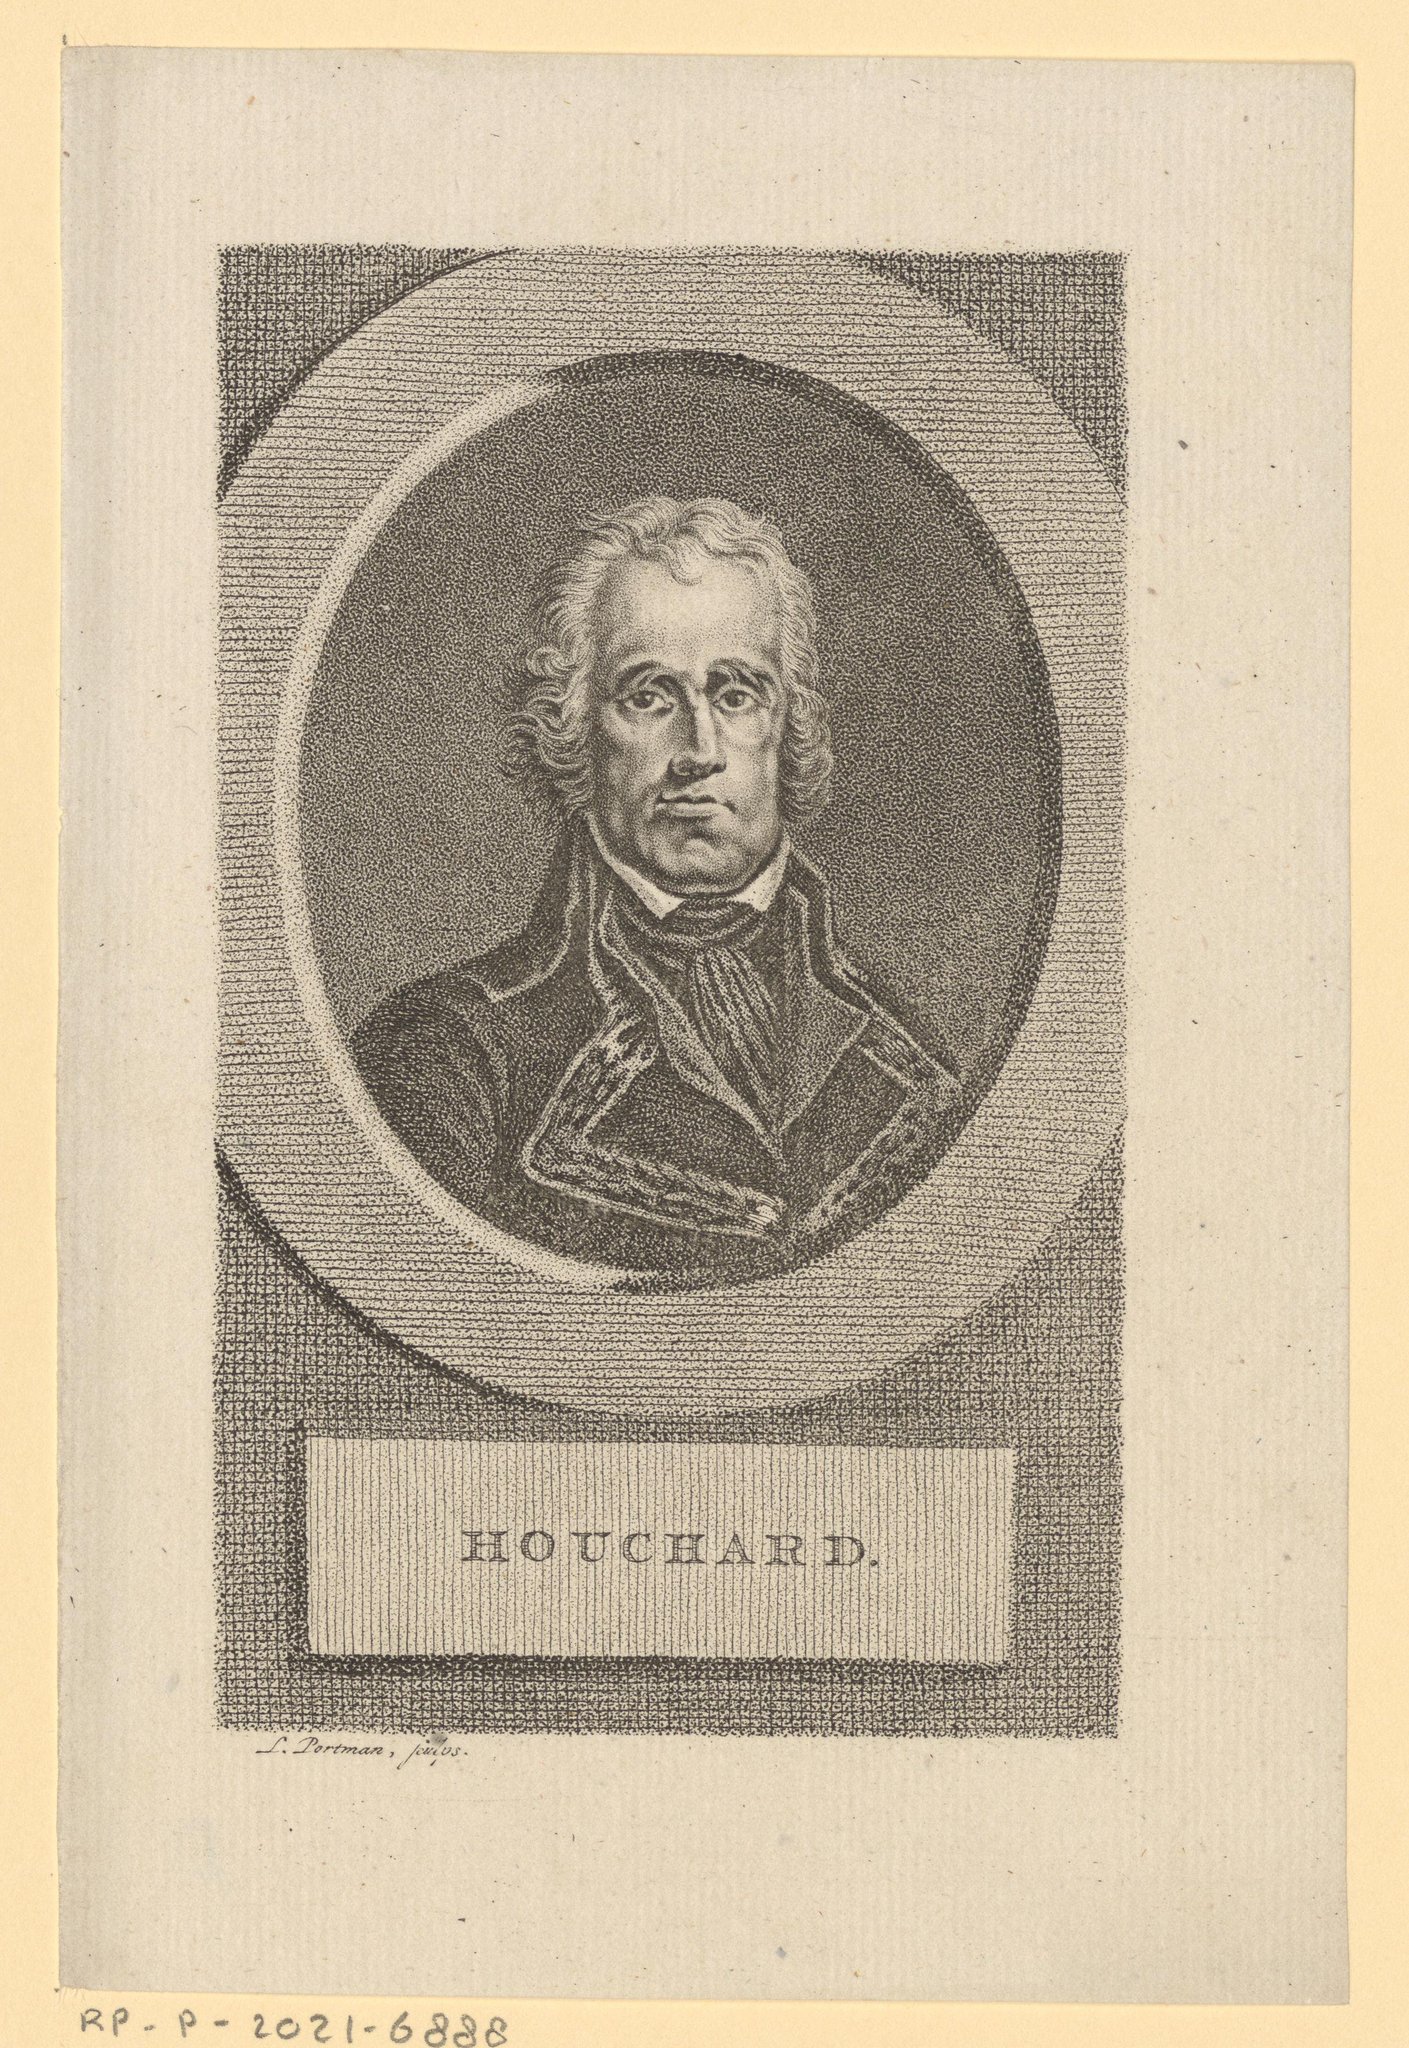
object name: print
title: Portret van Jean Nicolas Houchard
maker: ludwig gottlieb portman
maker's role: print maker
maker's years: 1772-1828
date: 1787-1828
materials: paper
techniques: etching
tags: commander-in-chief, general, marshal, historical persons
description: Prent mogelijk uit: Tafereelen van de staatsomwenteling in Frankrijk. Amsterdam: Johannes Allart, 1803, dl. 17.